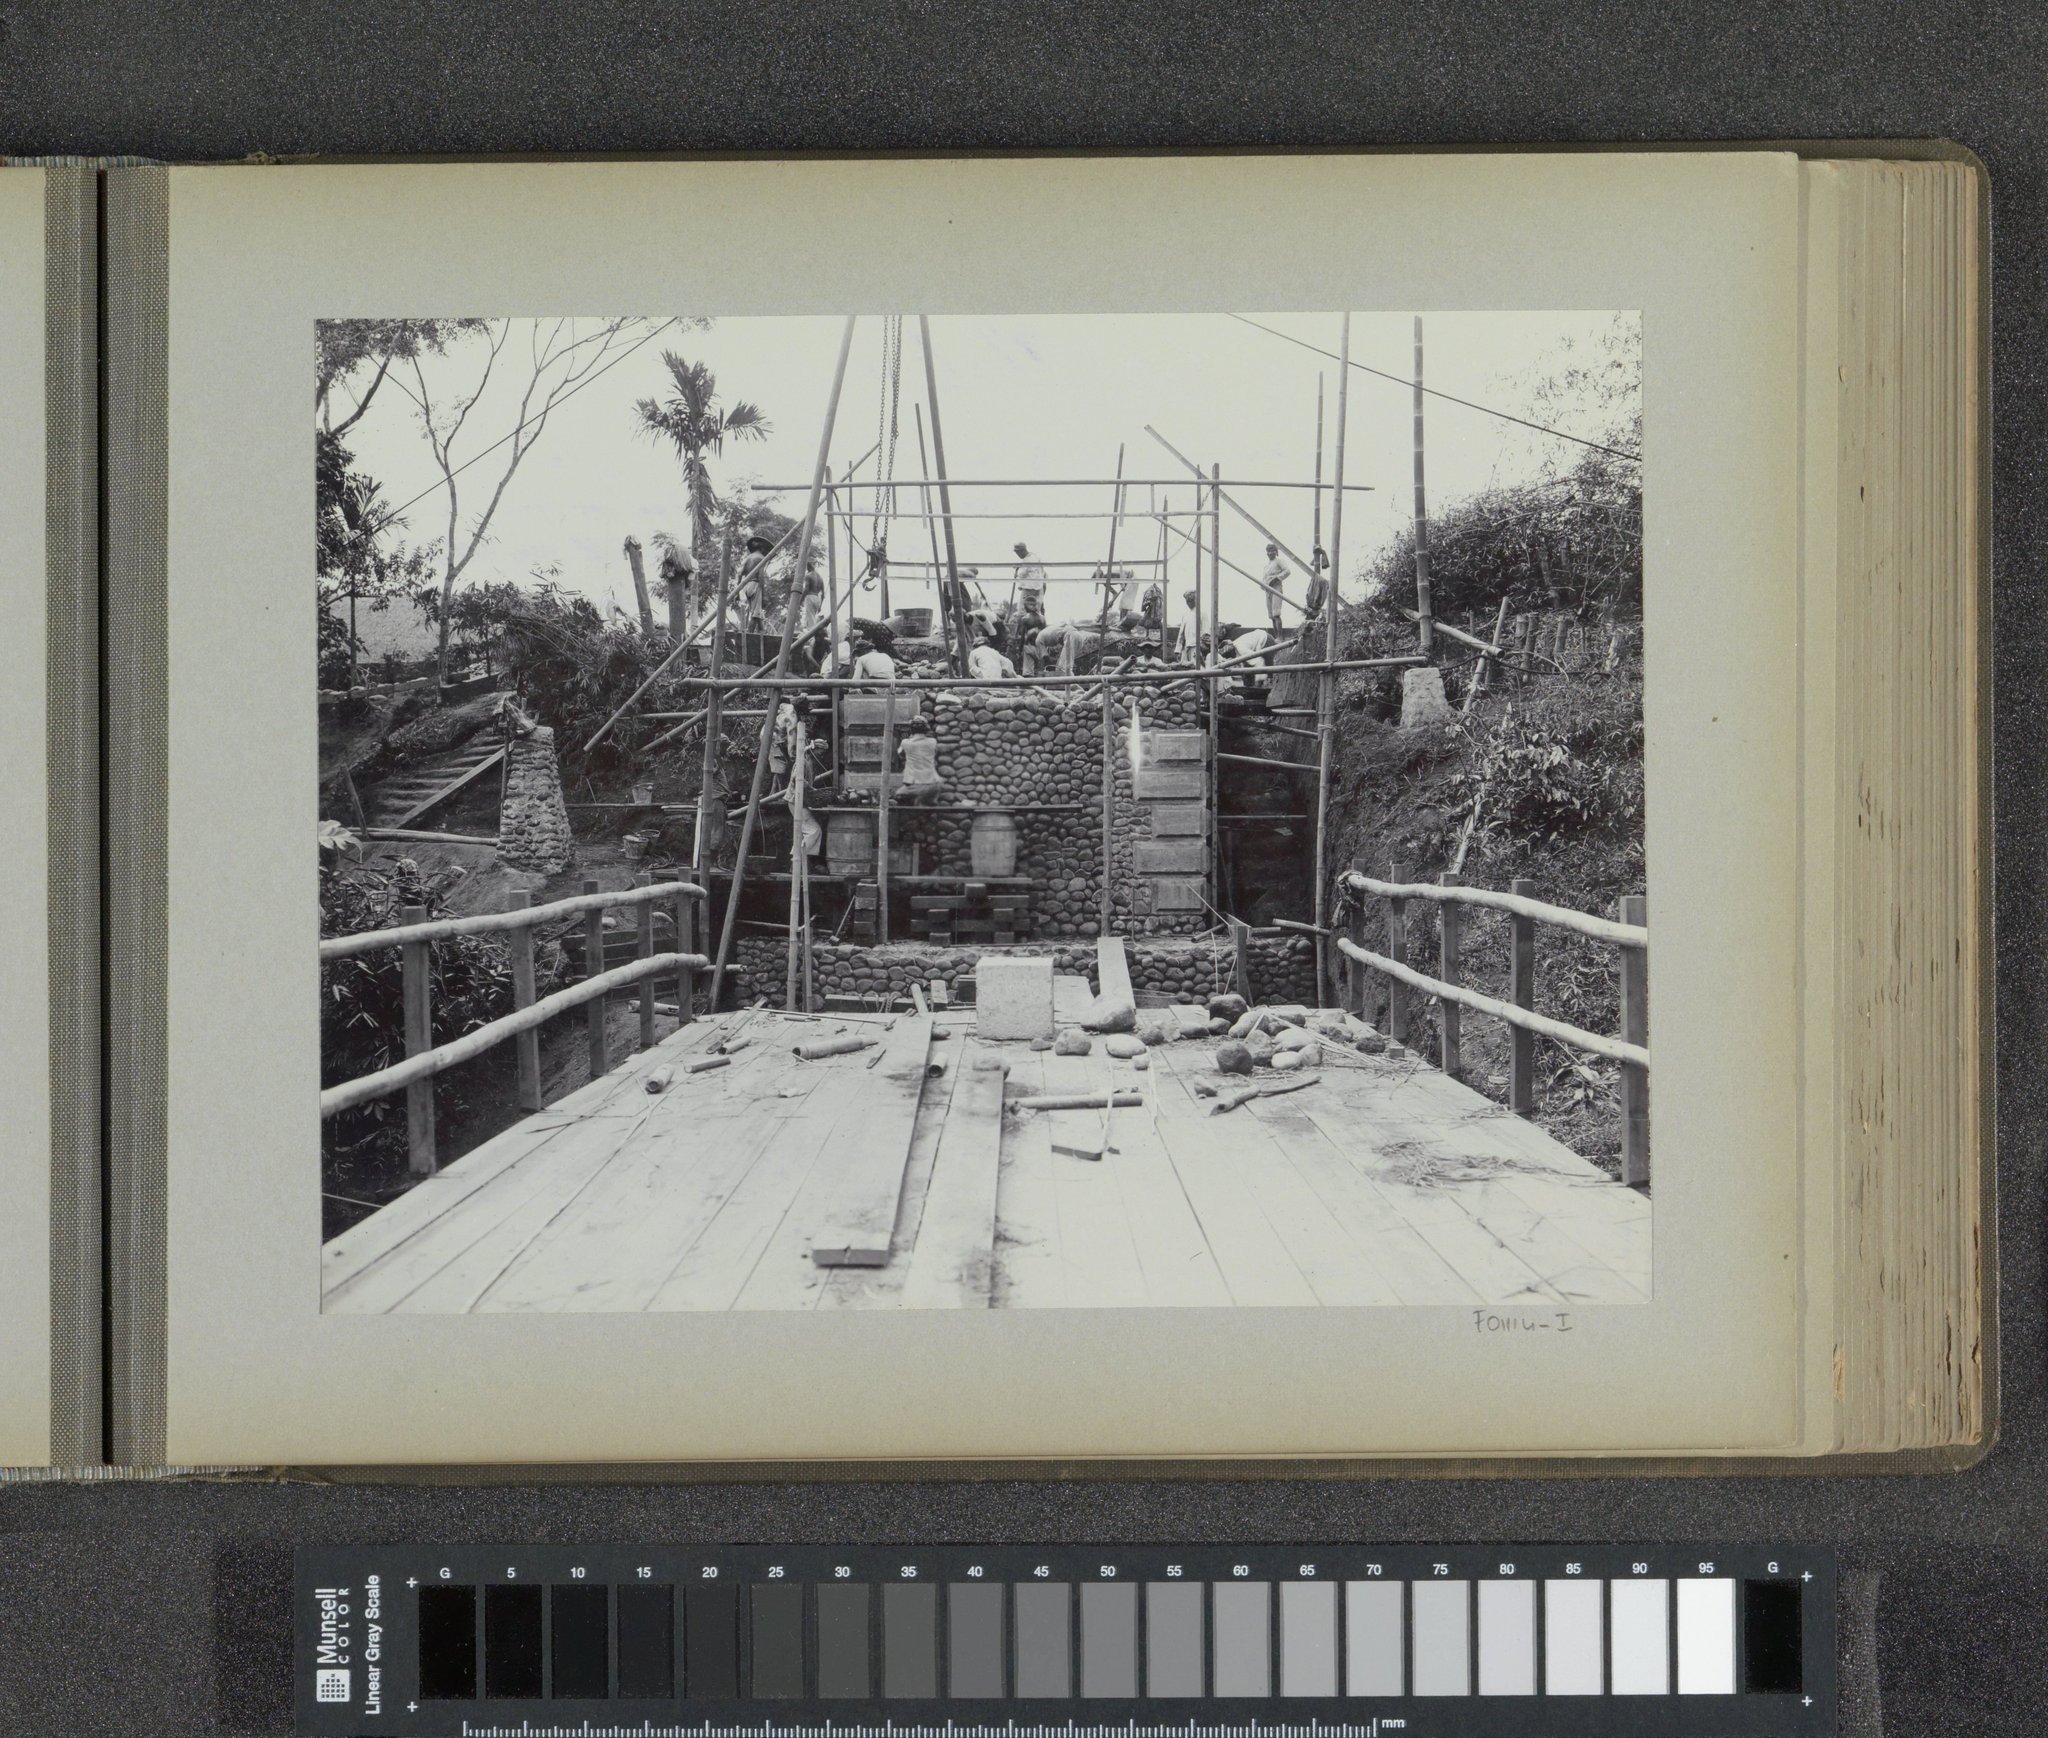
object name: album leaf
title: Bouw van een landhoofd op de oostelijke oever van de Kali Brantas ten zuiden van Malang, van dichtbij gezien (Photo IX)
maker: Anonymous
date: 1890-1920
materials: cardboard, paper, photographic support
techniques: gelatin silver print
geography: java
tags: scaffold (~ building activities), engineering, landscape with bridge, viaduct or aqueduct, working class, labourers, bridge, building-site, java, dutch east indies, the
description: Foto met op de linkerpagina het bijbehorende bijschrift. Onderdeel van Fotoalbum met opnames van de bouw van een brug over de Kali Brantas ten zuiden van Malang op Java.